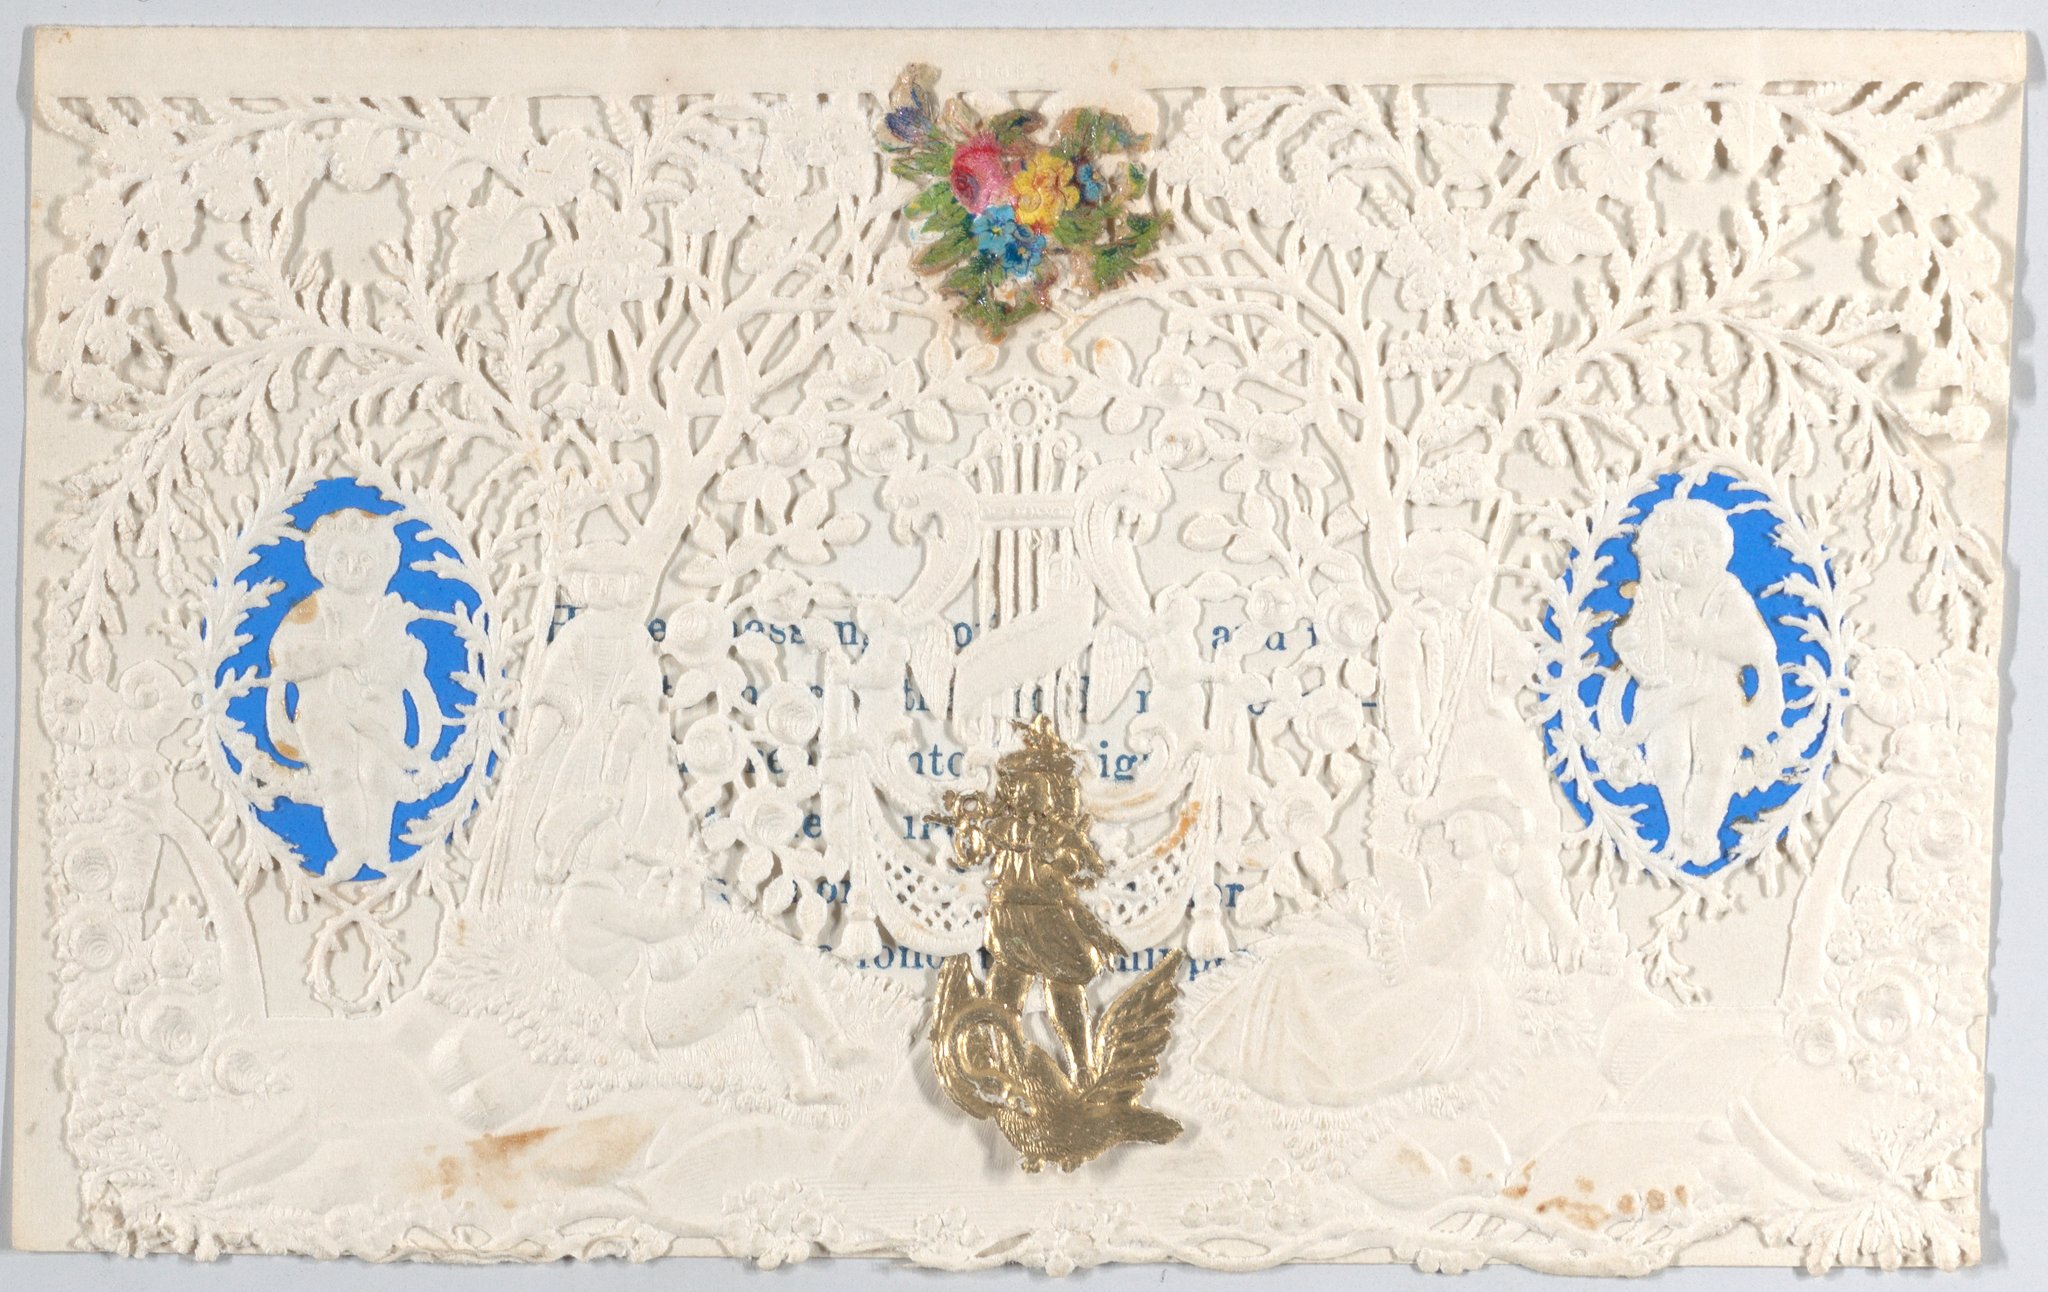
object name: valentine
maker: Anonymous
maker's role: artist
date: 1850-1870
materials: ink, lace, paper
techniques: cutting, embossing, open work